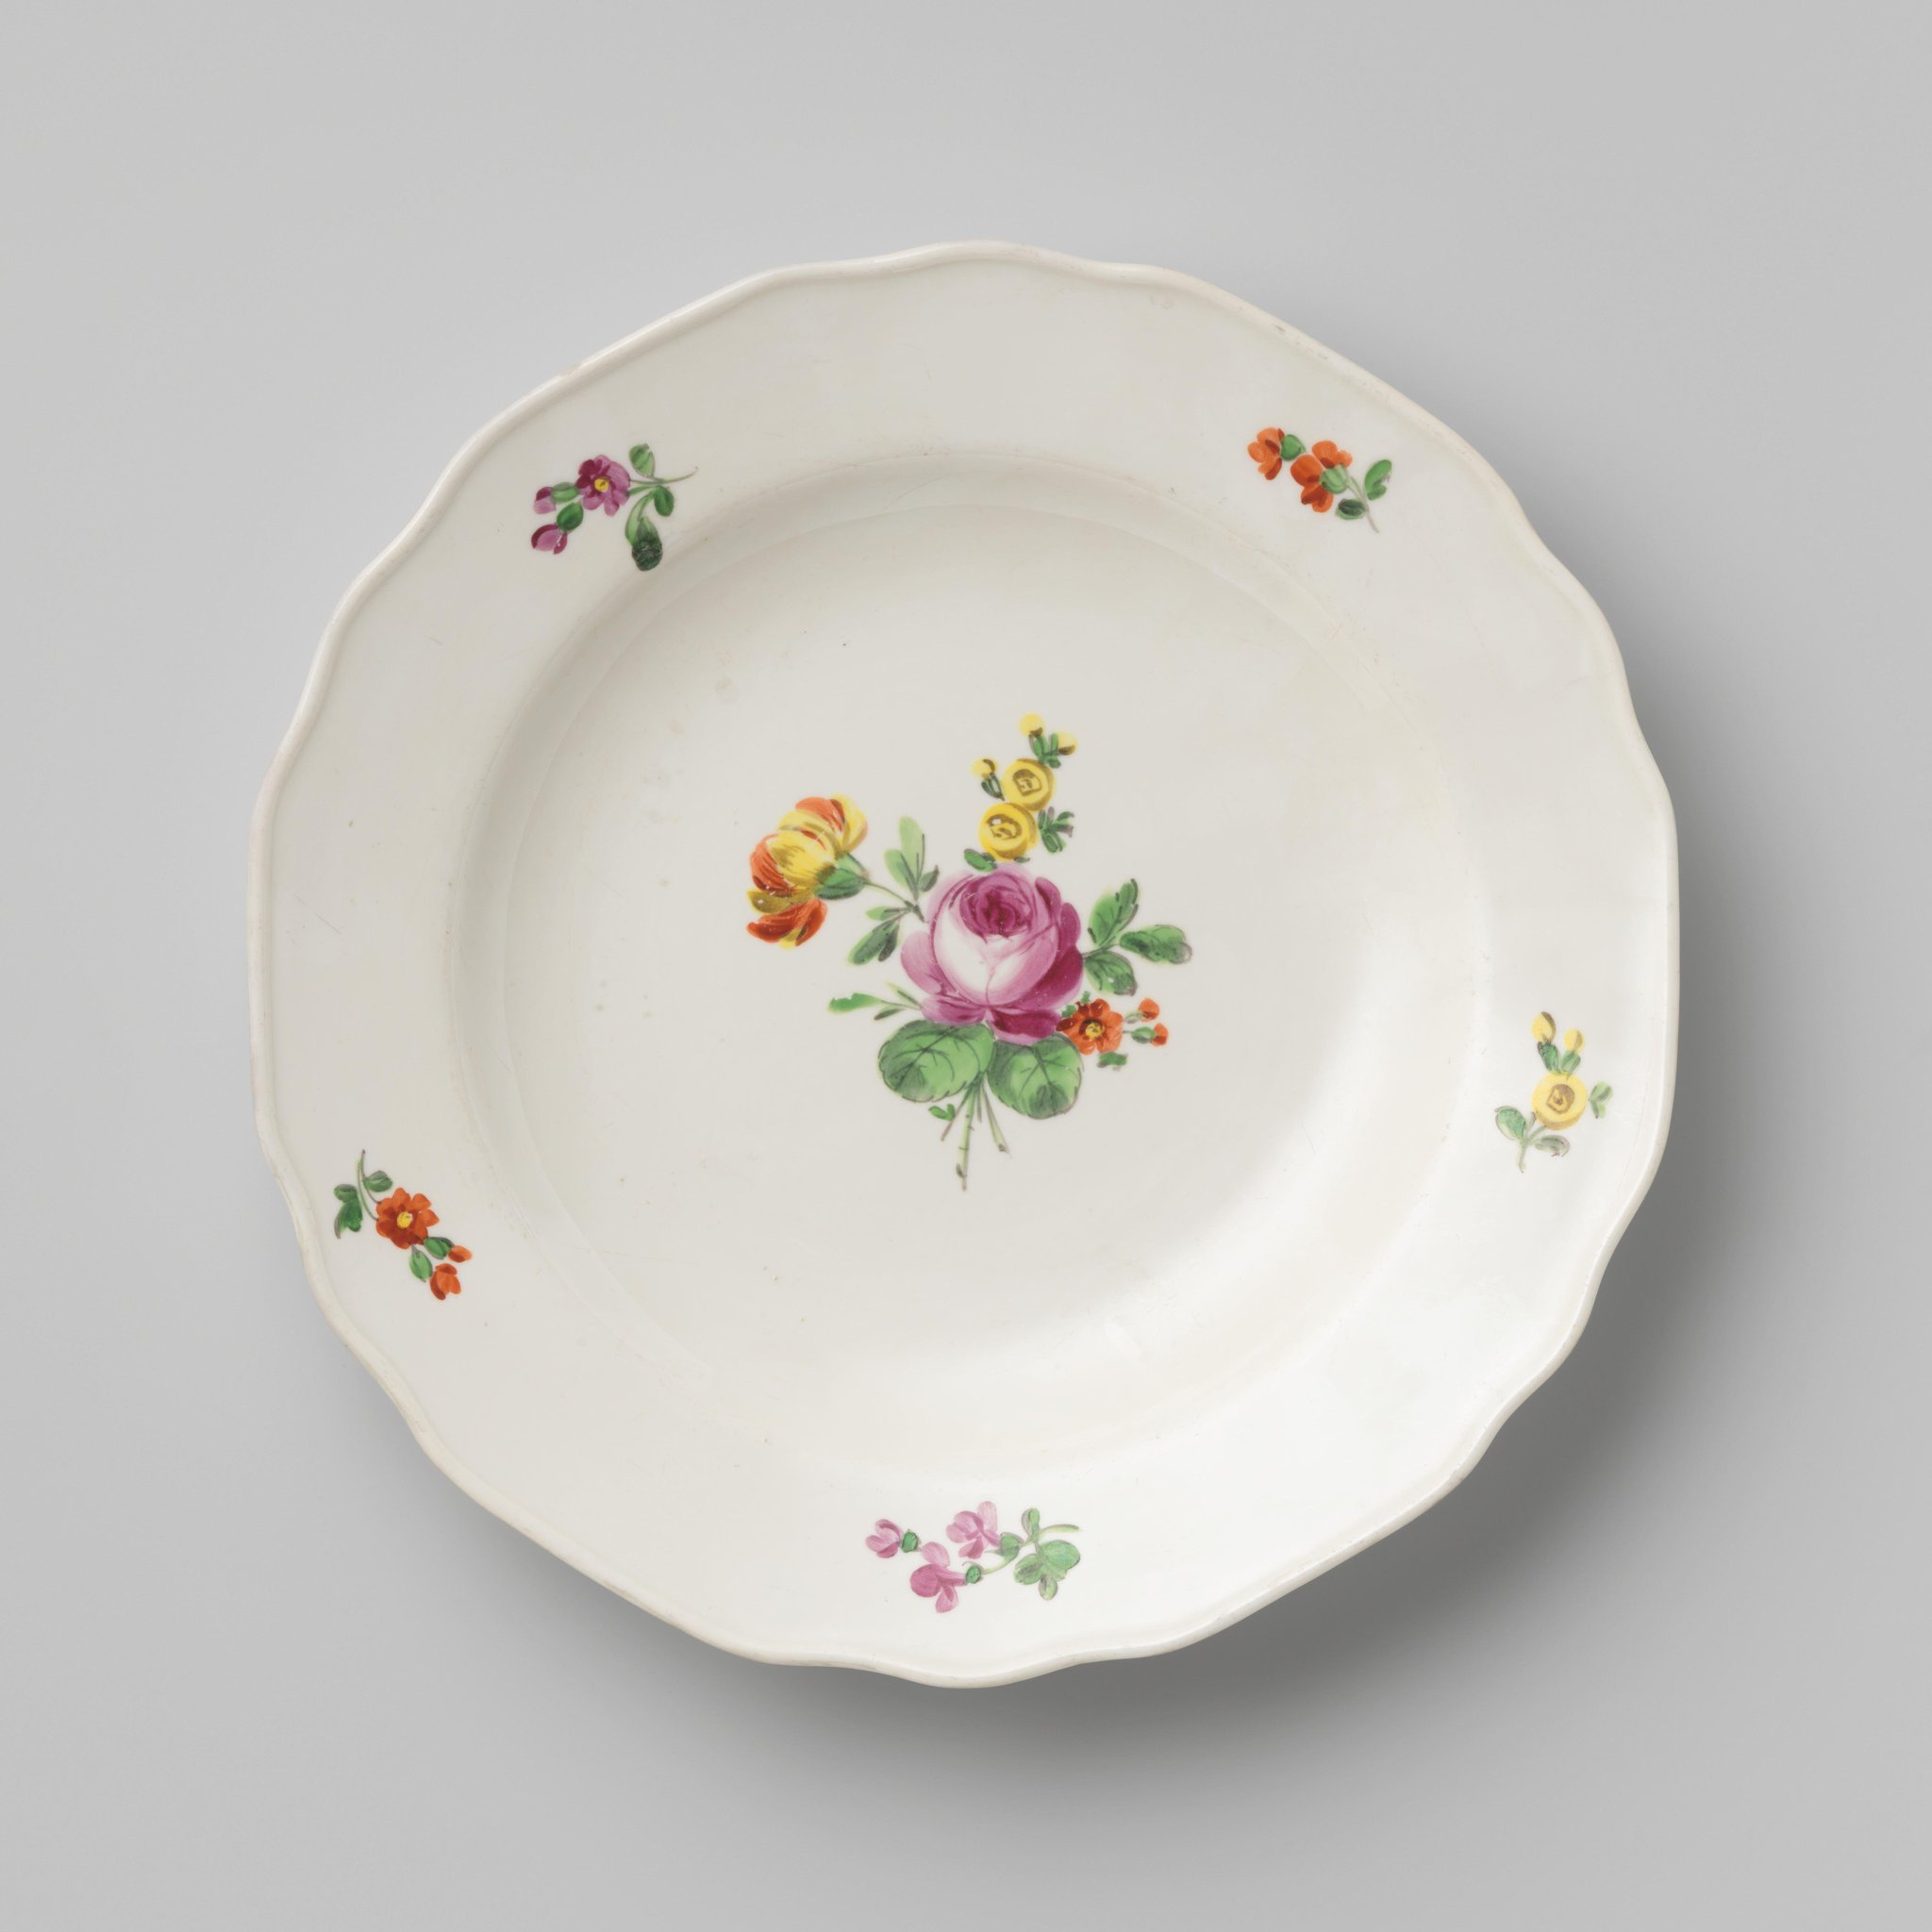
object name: service set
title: Plate with a bouquet and flower sprays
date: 1800-1849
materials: glaze, paint, porcelain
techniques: firing, forming, turning, vitrification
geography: vienna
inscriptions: mark: ‘schild/ P[?]/ C/ 30/ 26/ 2/ horizontale streep’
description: Bord van porselein met een gelobde rand, beschilderd op het glazuur in rood, roze, groen en geel. Op het plat een boeket van verschillende bloemen (o.a. pioenroos) omgeven door losse takjes en op de rand vijf bloemtakken. Gemerkt op de onderzijde met het schild, de letters P[...], C en de nummers 30, 26, 5 en een horizontale streep.